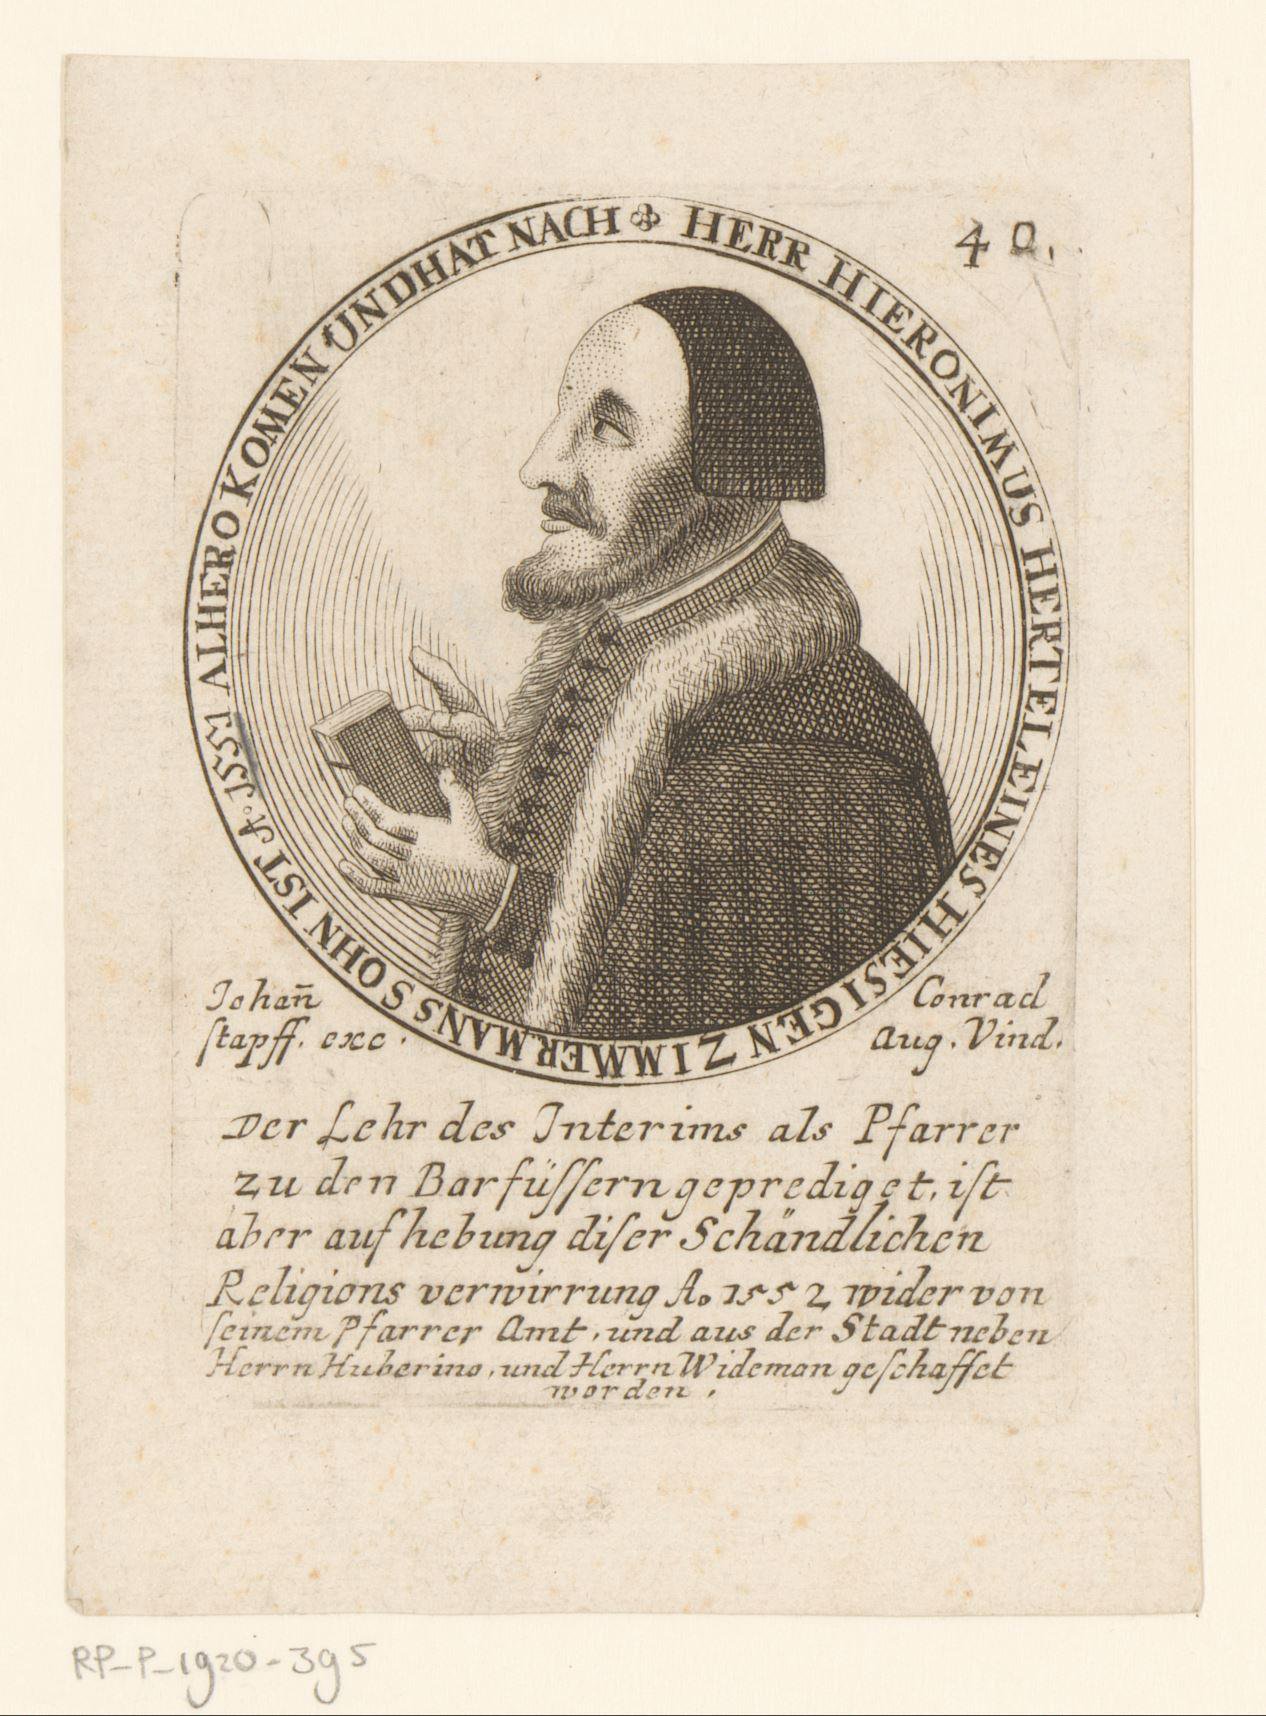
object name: print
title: Portret van Hieronymus Hertel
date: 1551-1600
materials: paper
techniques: engraving, etching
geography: augsburg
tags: historical persons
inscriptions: collector's mark: Lugt 2228